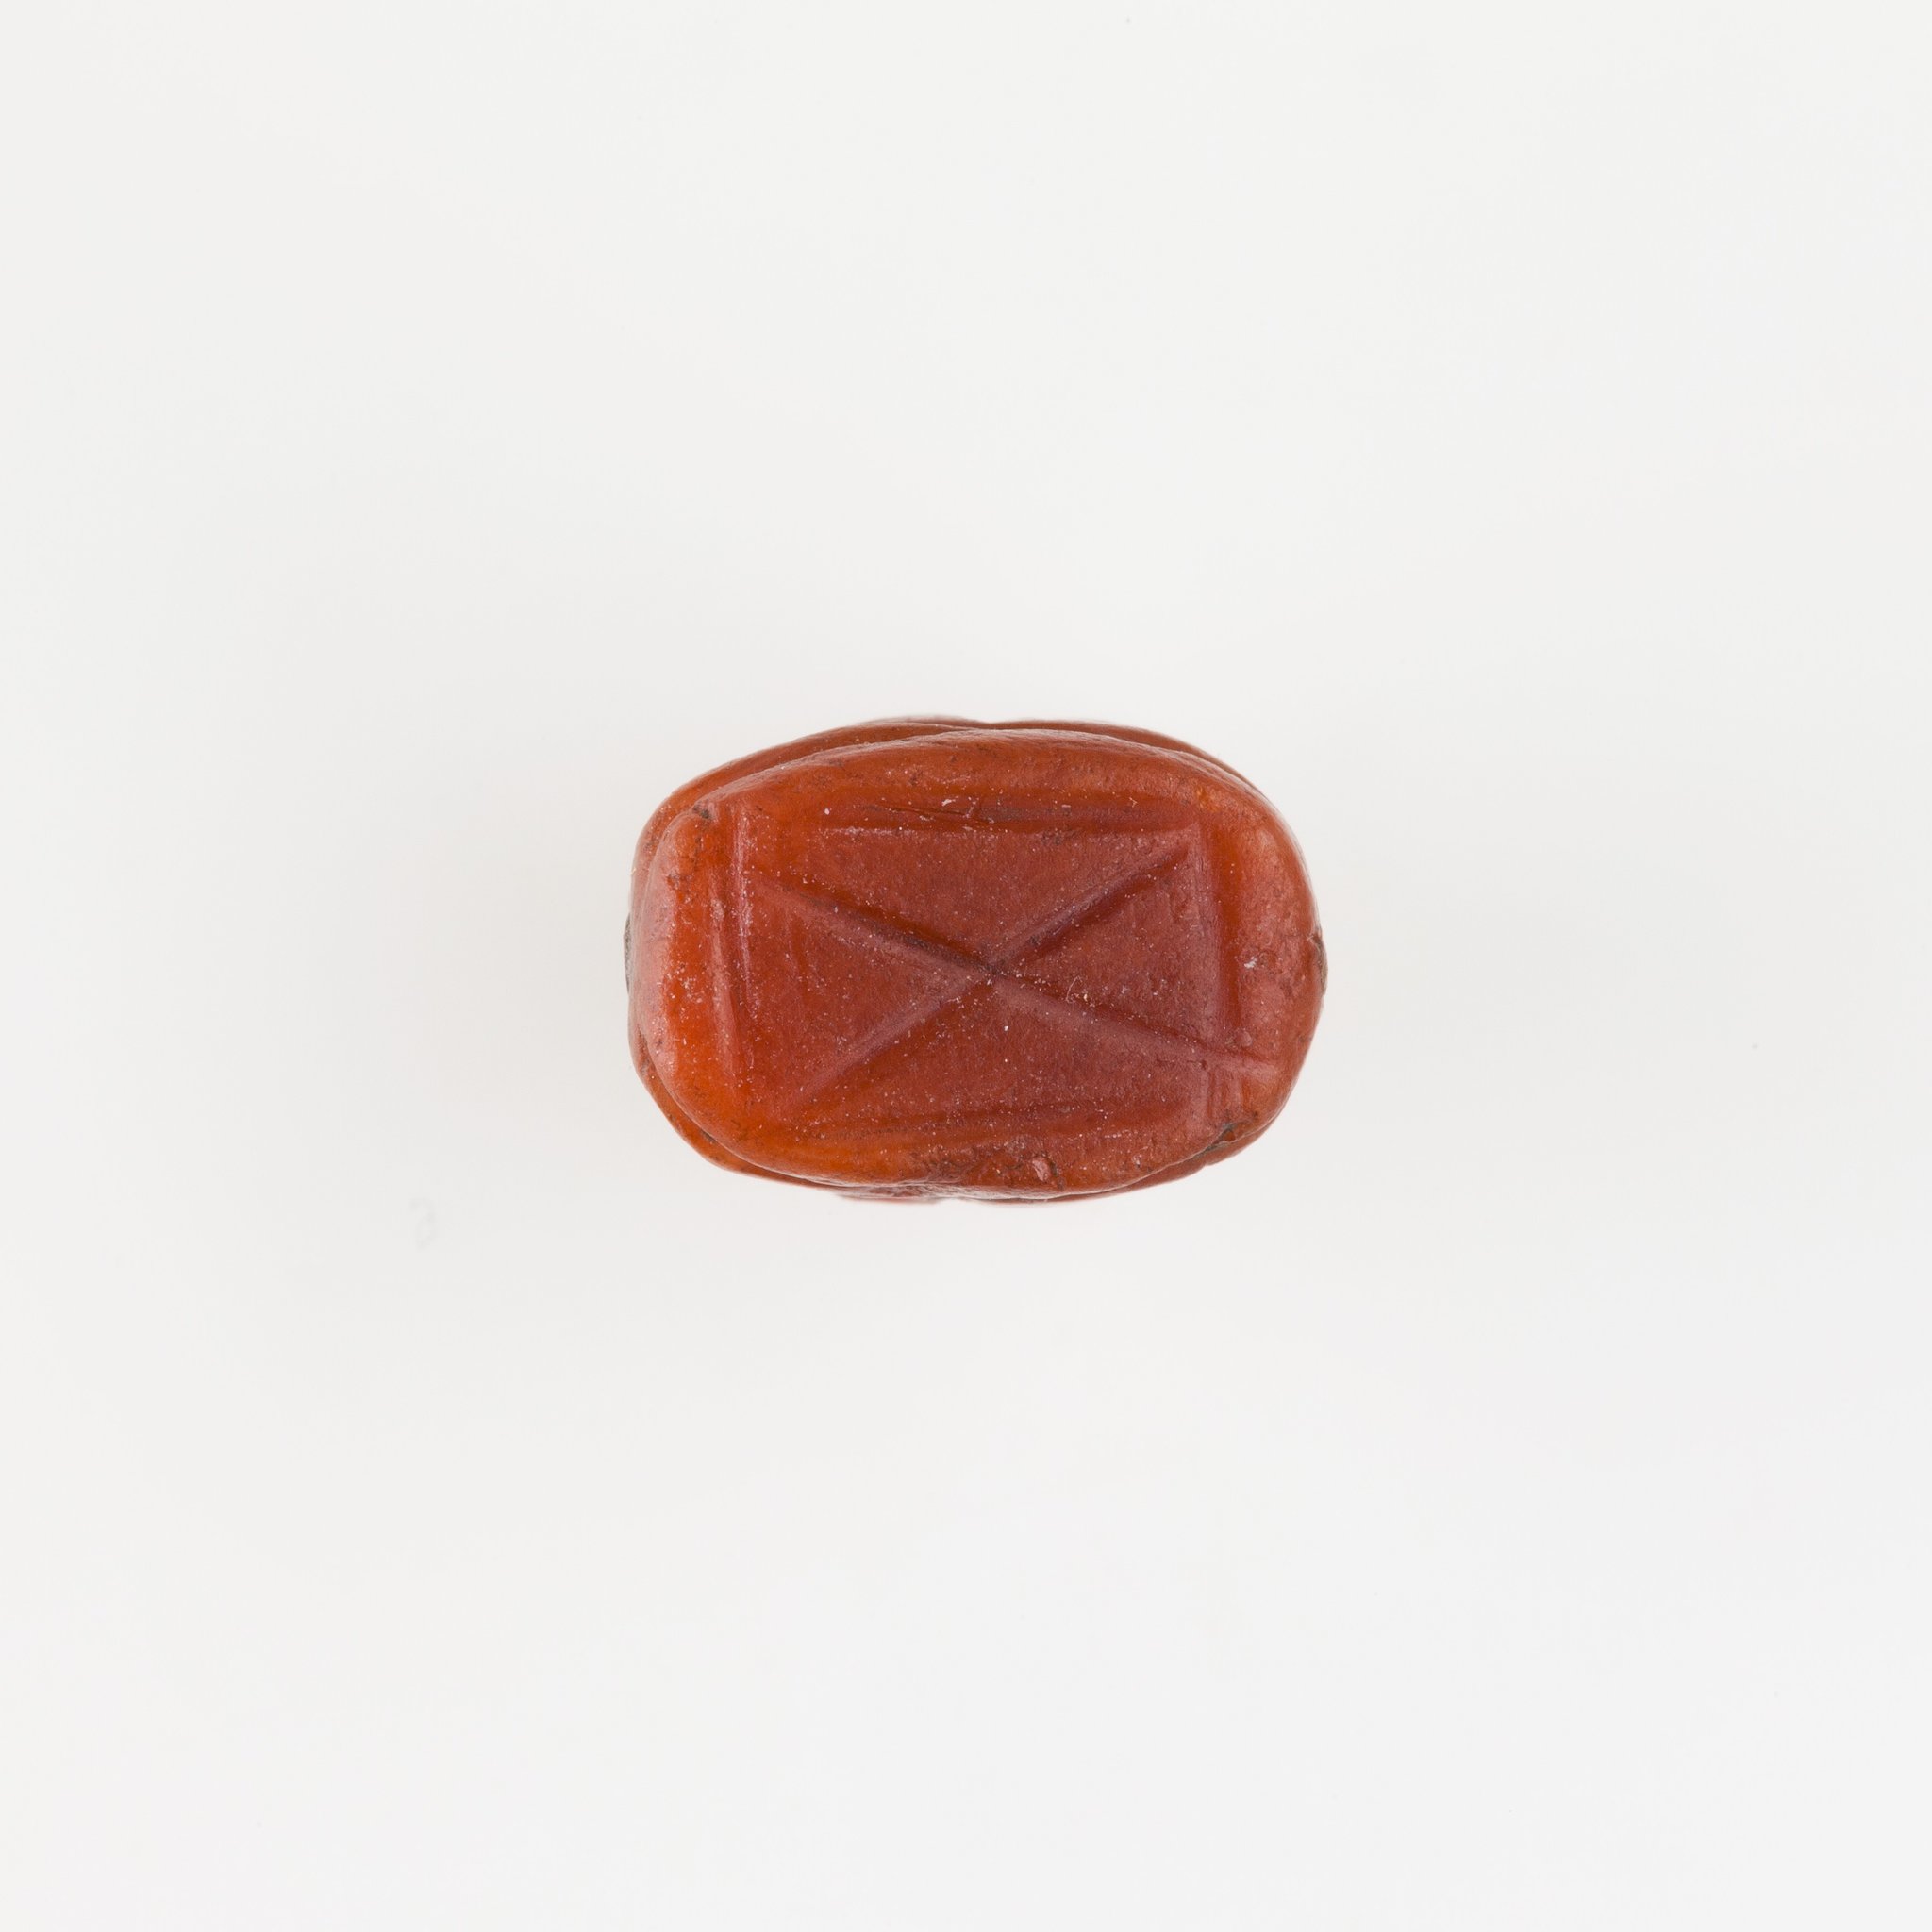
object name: scarab, geometric, cross, linear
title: Scarab Decorated with Crossing Lines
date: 1550-1295 BCE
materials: gemstone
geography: egypt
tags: scarabs